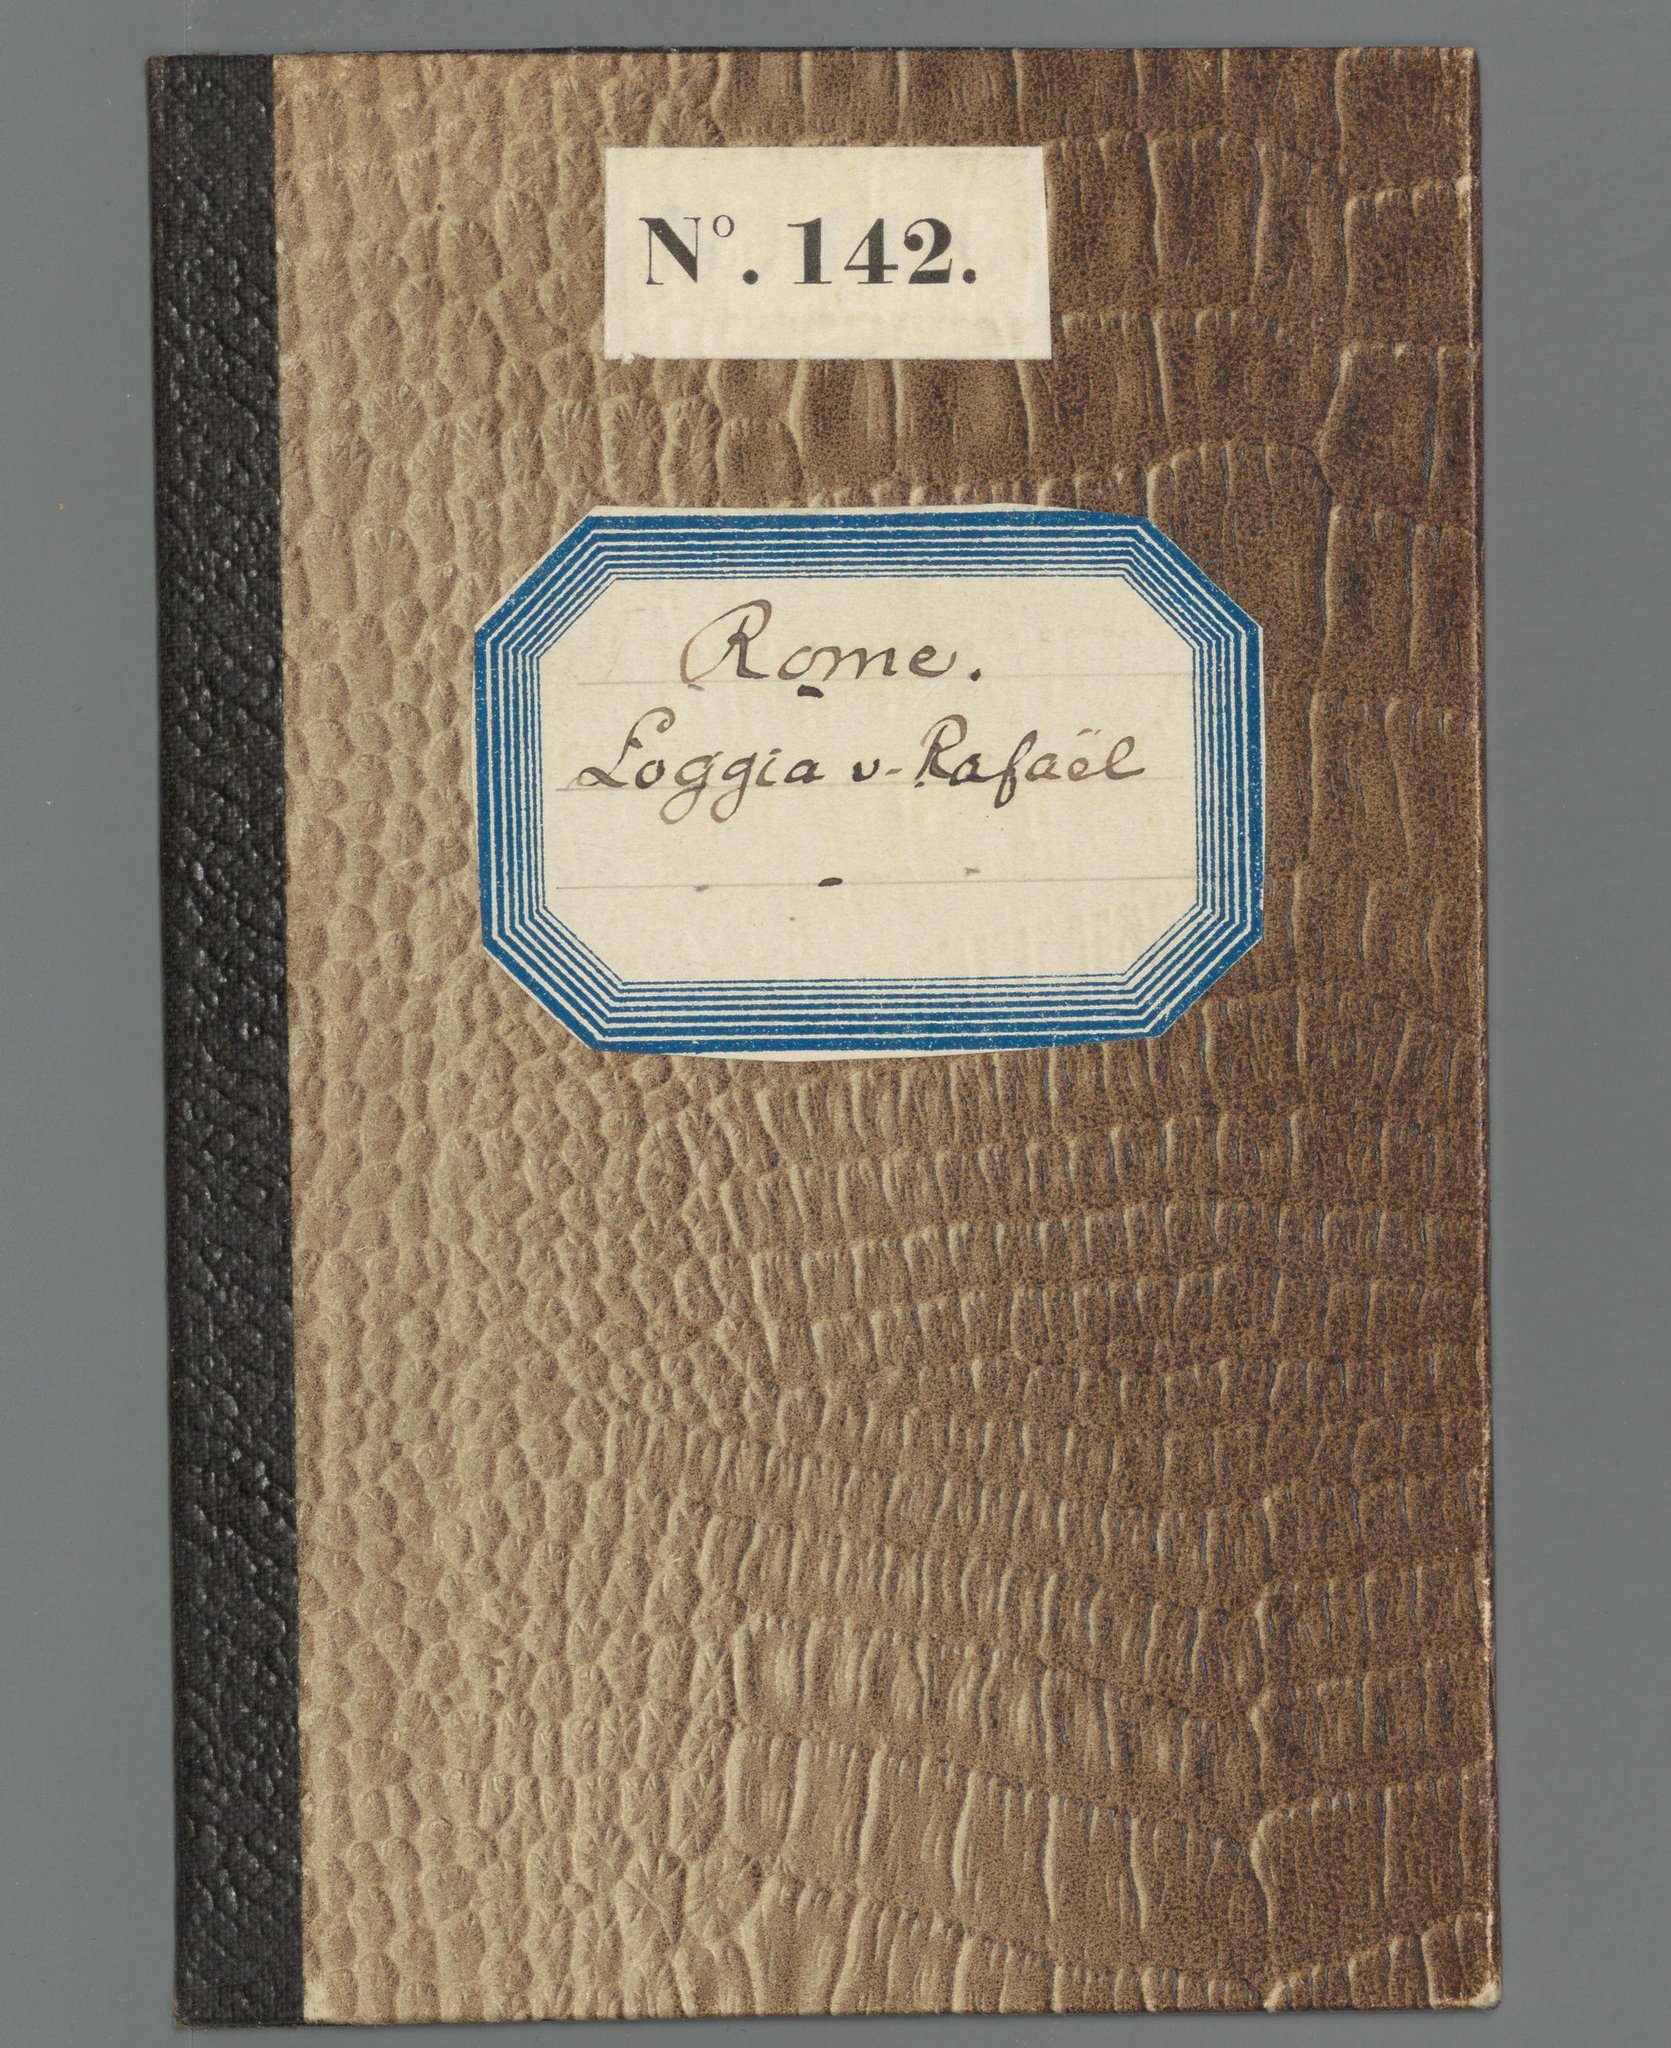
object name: wrapper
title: Rome. Loggia v. Rafaël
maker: Anonymous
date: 1900-1950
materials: cardboard, ink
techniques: pen